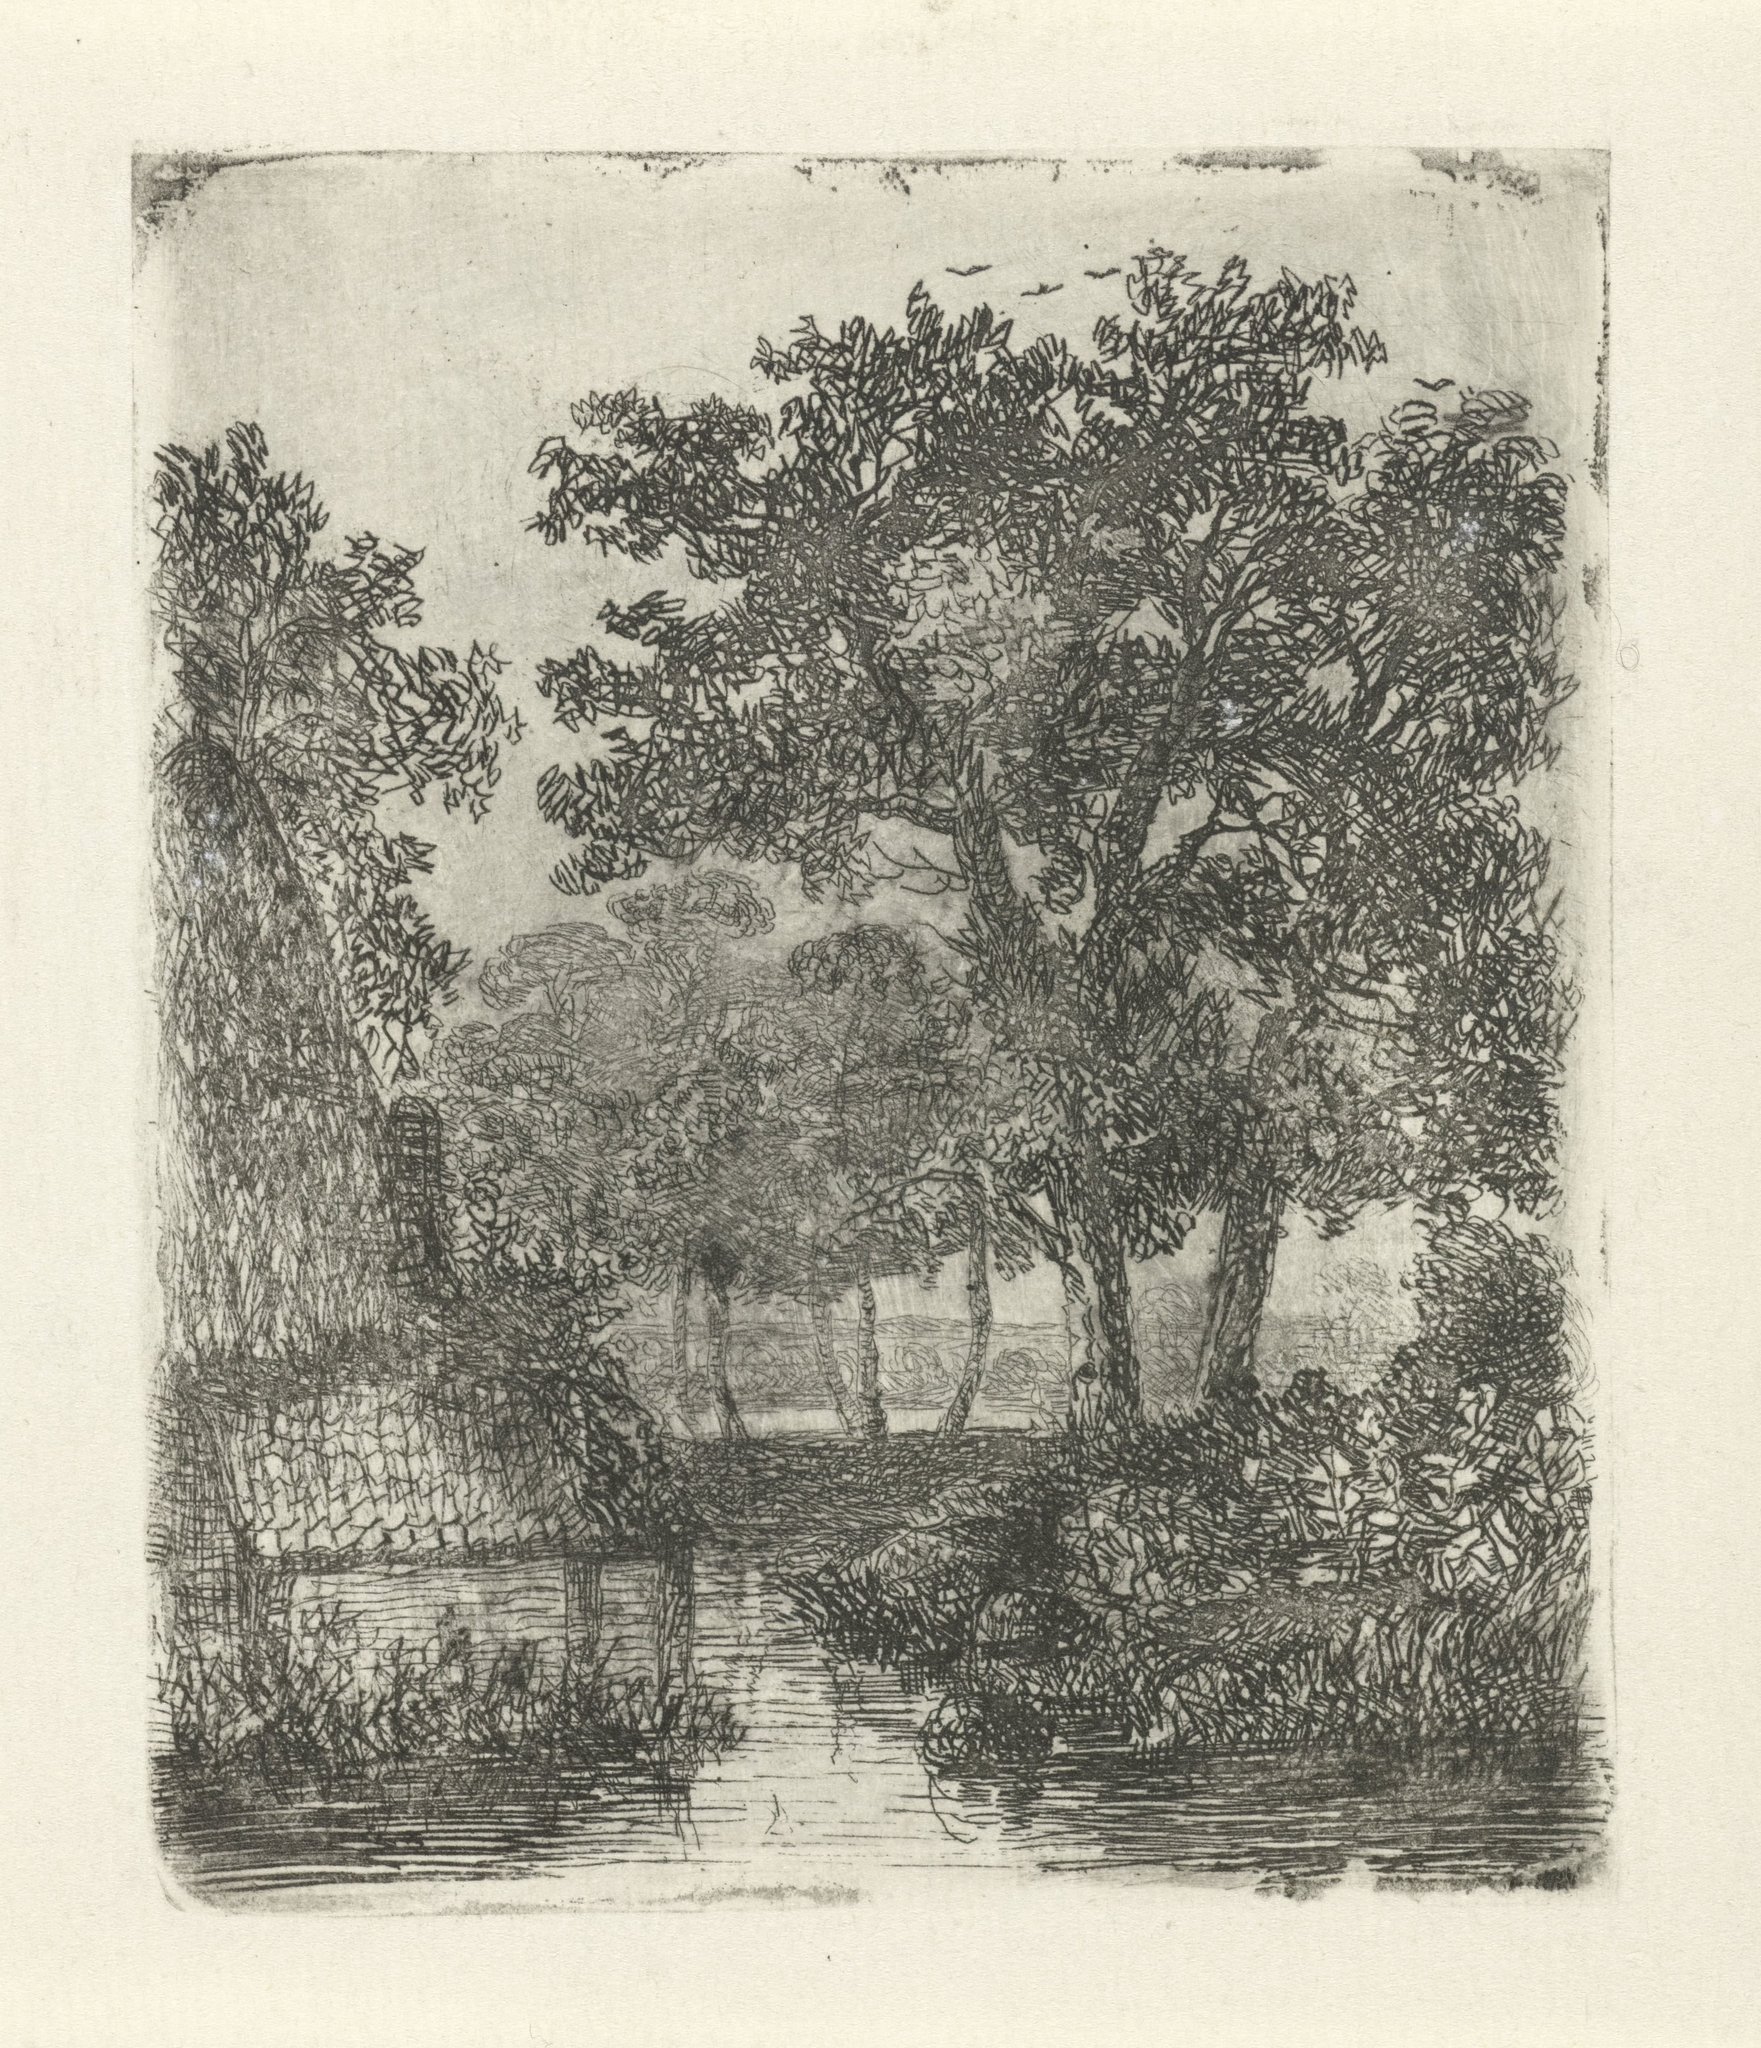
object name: print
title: Boomrijk gebied met beekjes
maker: hermanus jan hendrik van rijkelijkhuysen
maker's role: painter, print maker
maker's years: 1813-1883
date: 1823-1883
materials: paper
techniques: etching, intaglio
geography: utrecht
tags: trees, river, boat-house, shed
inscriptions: collector's mark: Lugt 2228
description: Gezicht op een boomrijk gebied met beekjes. Links een schuitenhuis.